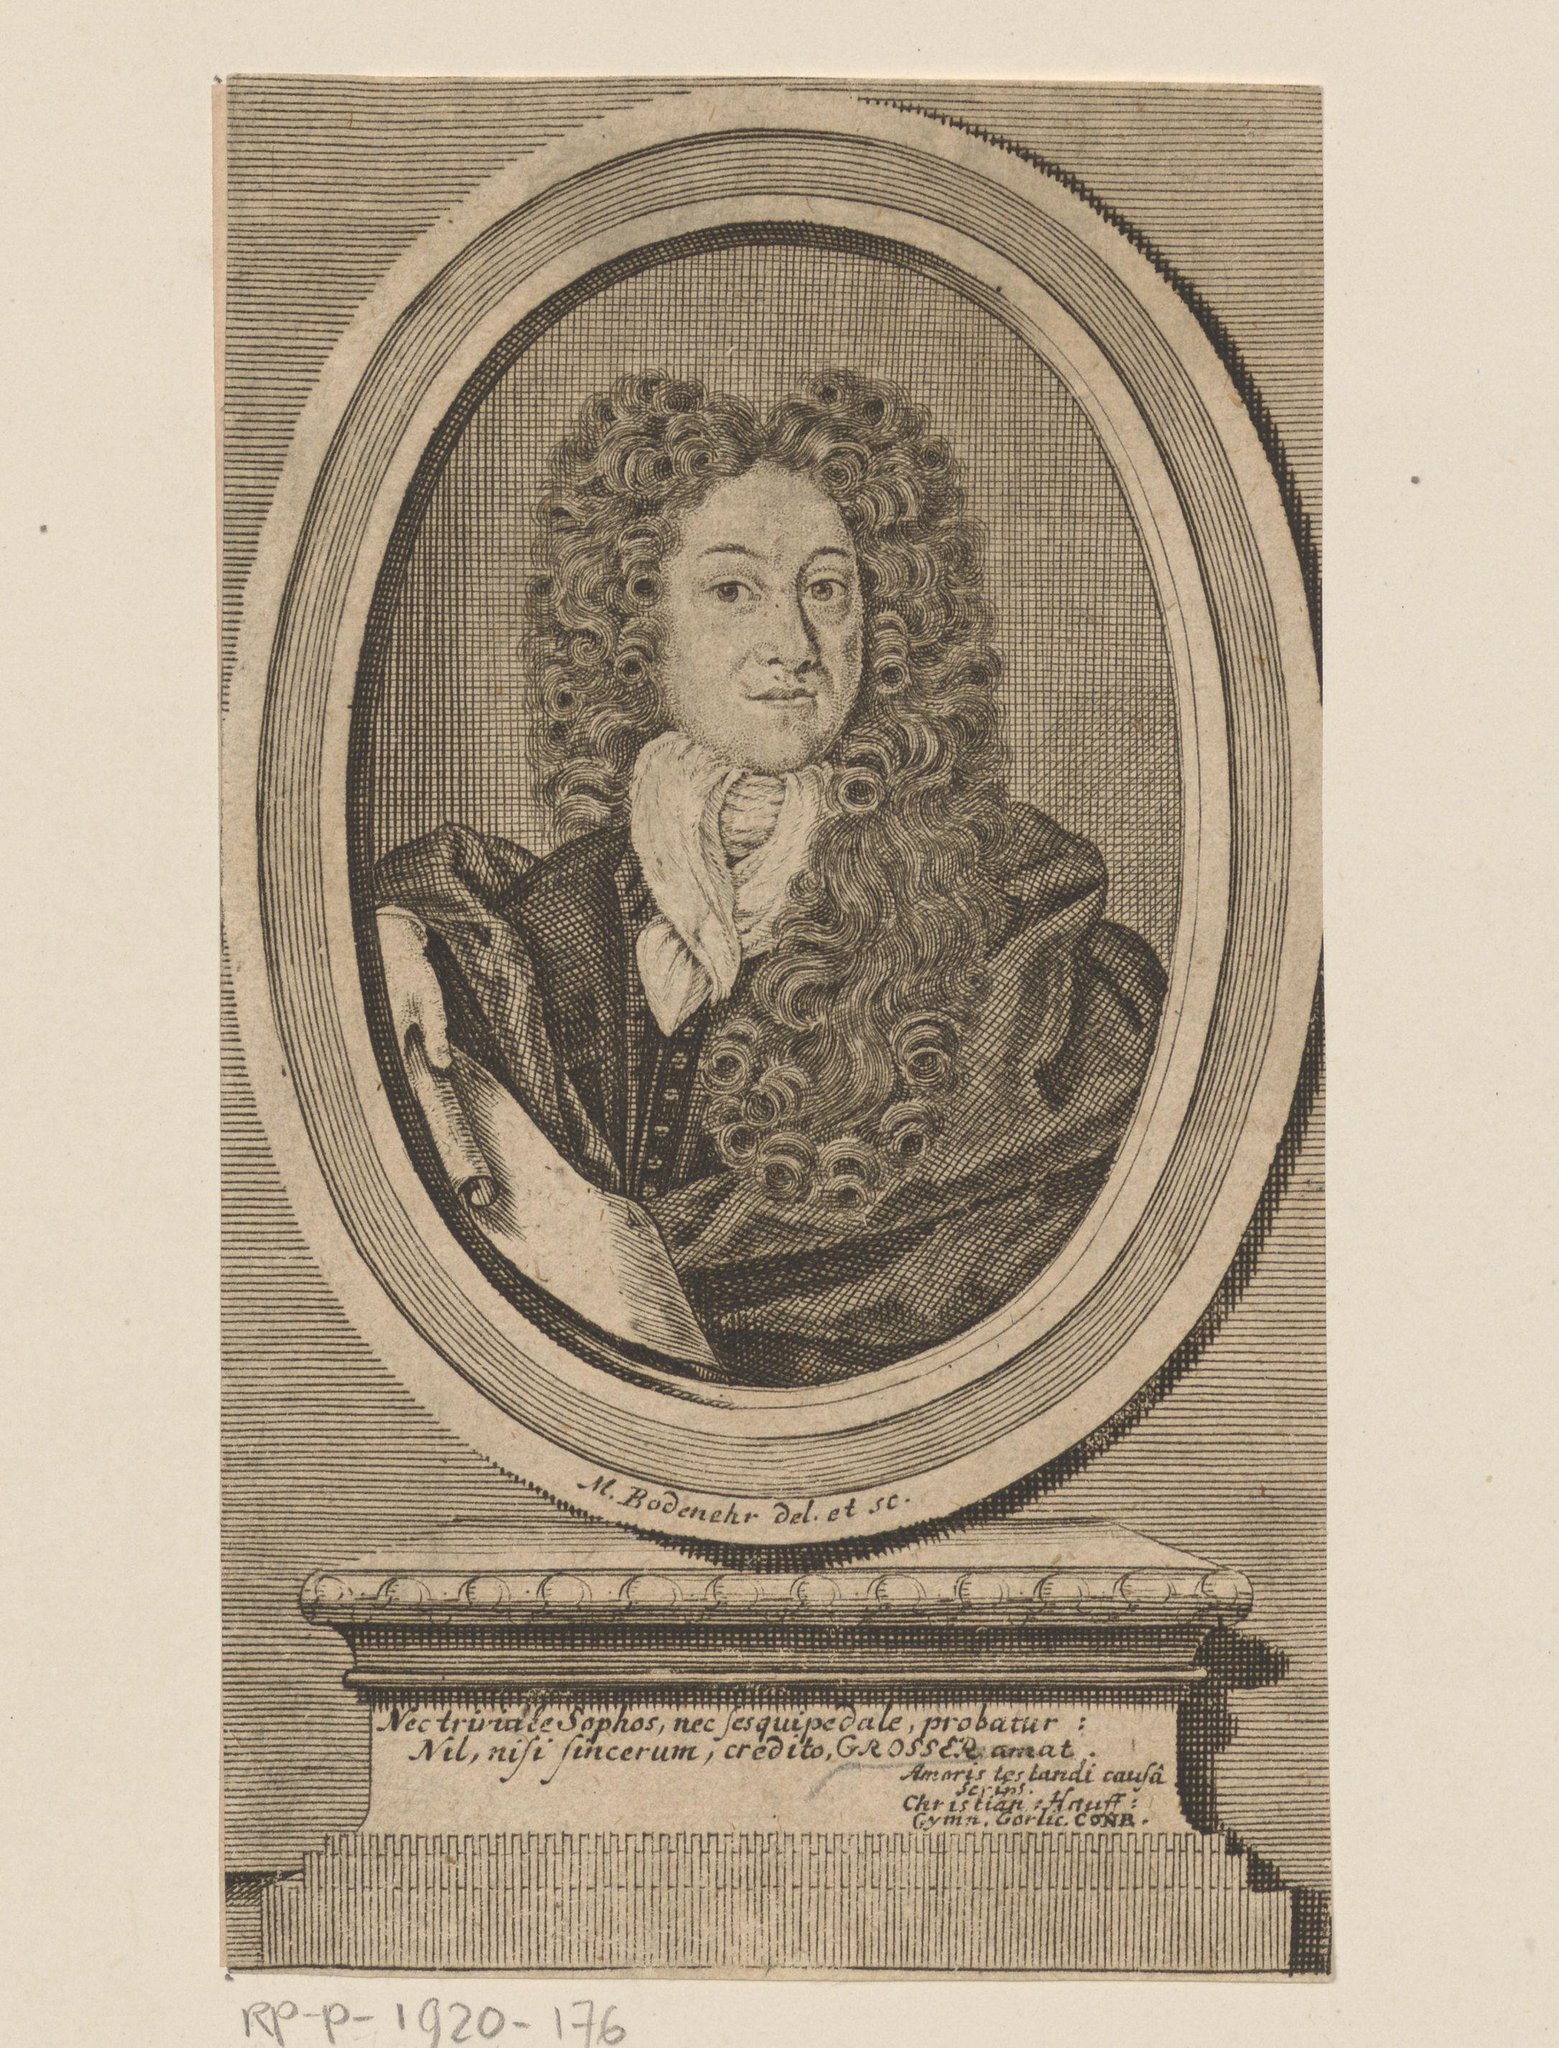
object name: print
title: Portret van Samuel Grosser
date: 1675-1748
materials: paper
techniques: engraving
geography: görlitz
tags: historical persons, professor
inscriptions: collector's mark: Lugt 2228